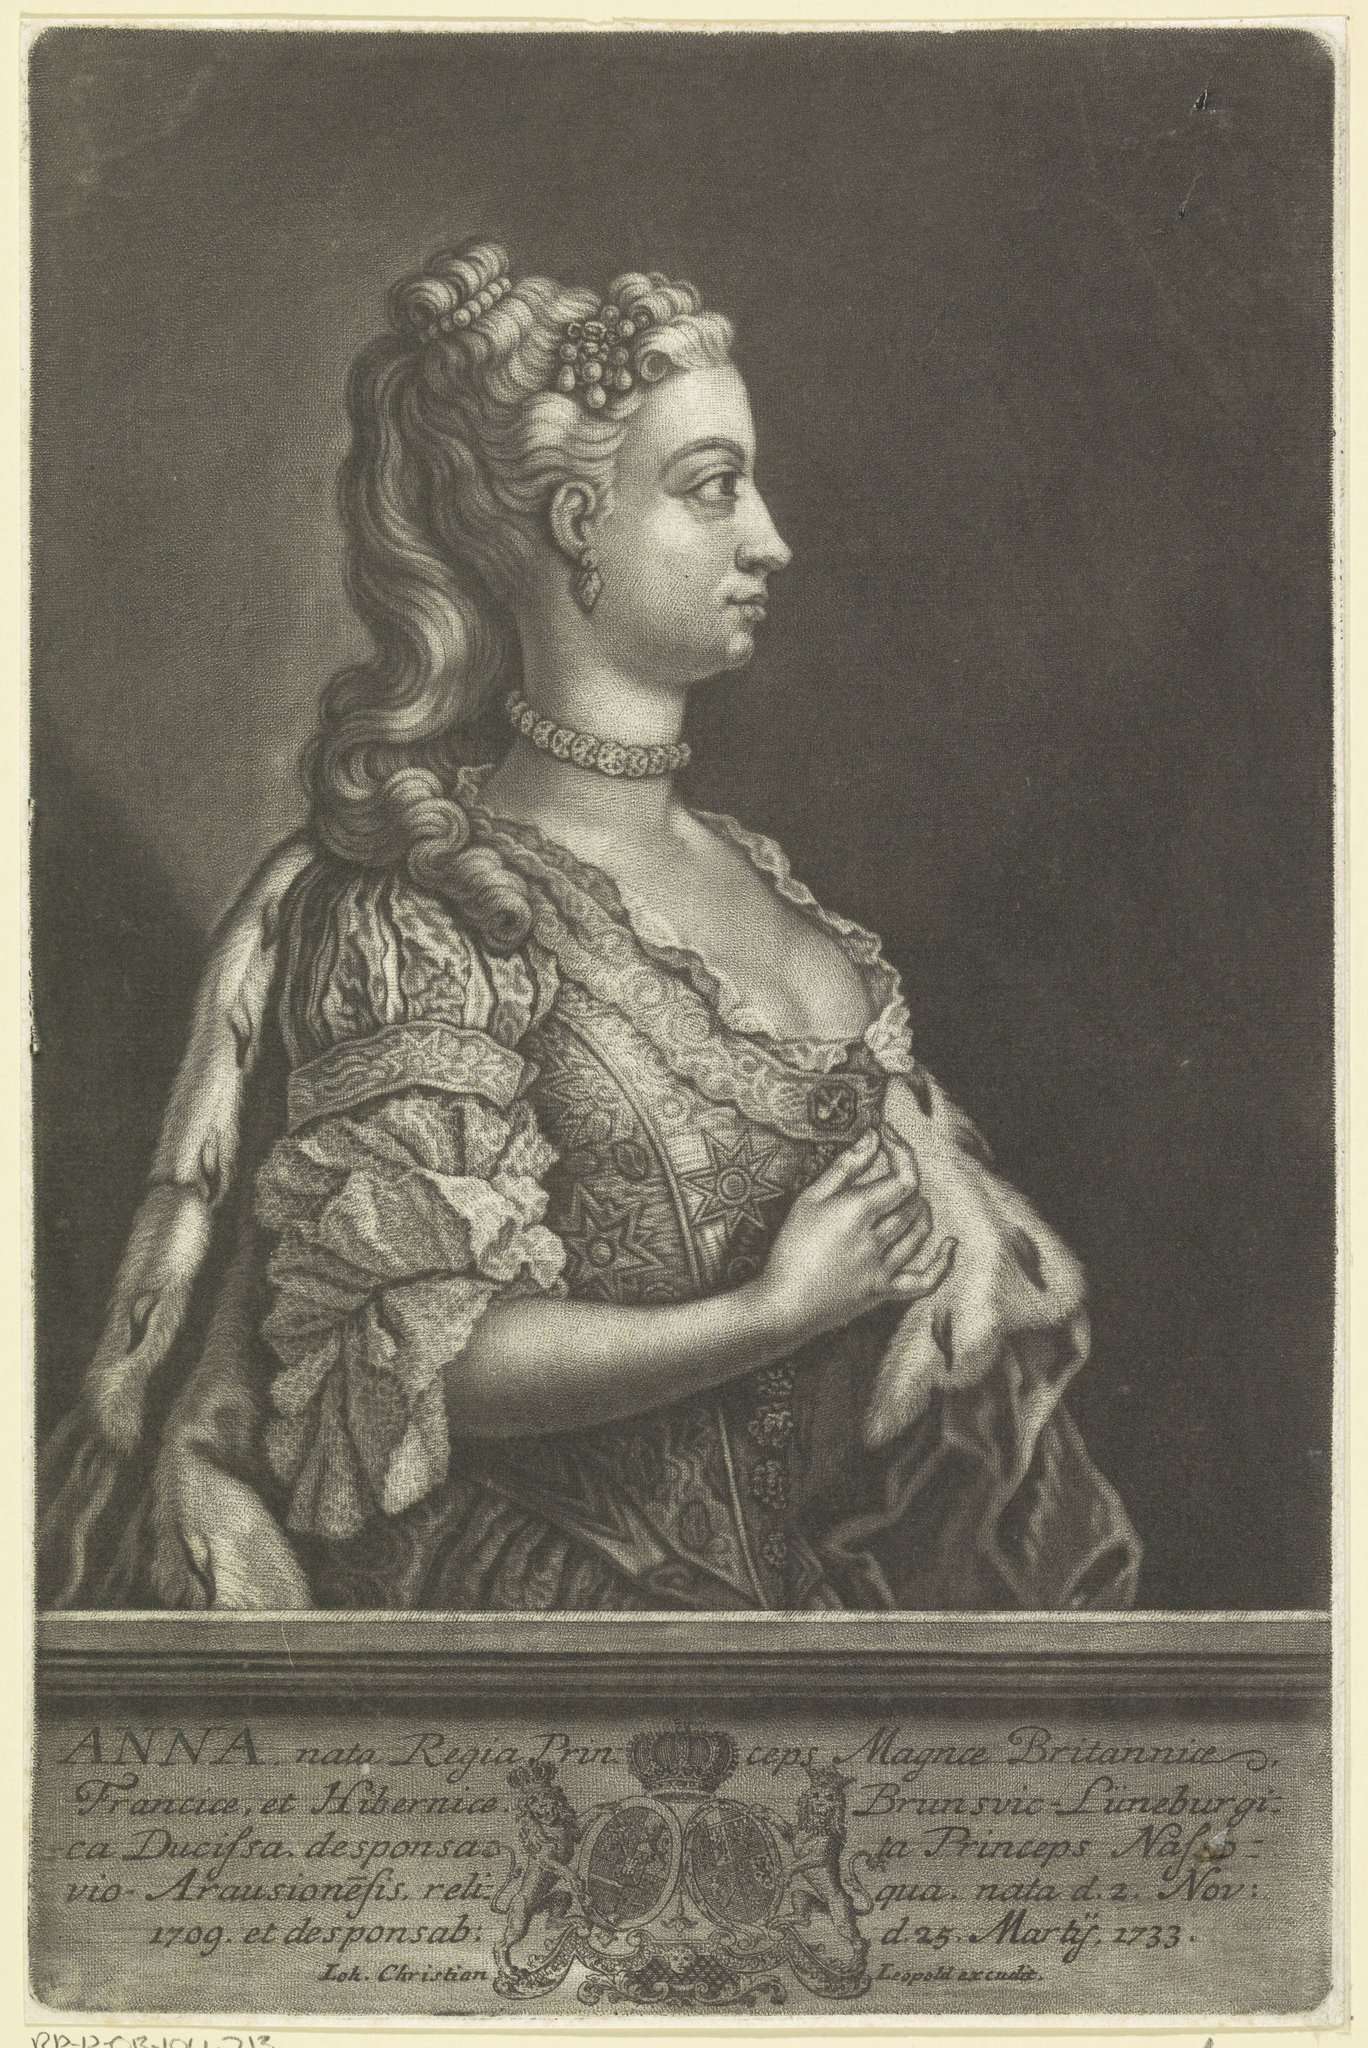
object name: print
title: Portret van Anna van Hannover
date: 1734-1755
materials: paper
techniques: mezzotint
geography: germany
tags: the hague, willem iv (prins van oranje-nassau), anna van hannover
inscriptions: collector's mark: Lugt 963, collector's mark: Lugt 2165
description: Portret van Anna. Midden onder haar wapen en het wapen van Willem IV met een kroon en twee leeuwen. In de ondermarge haar naam, titels, haar geboortedatum en trouwdatum.